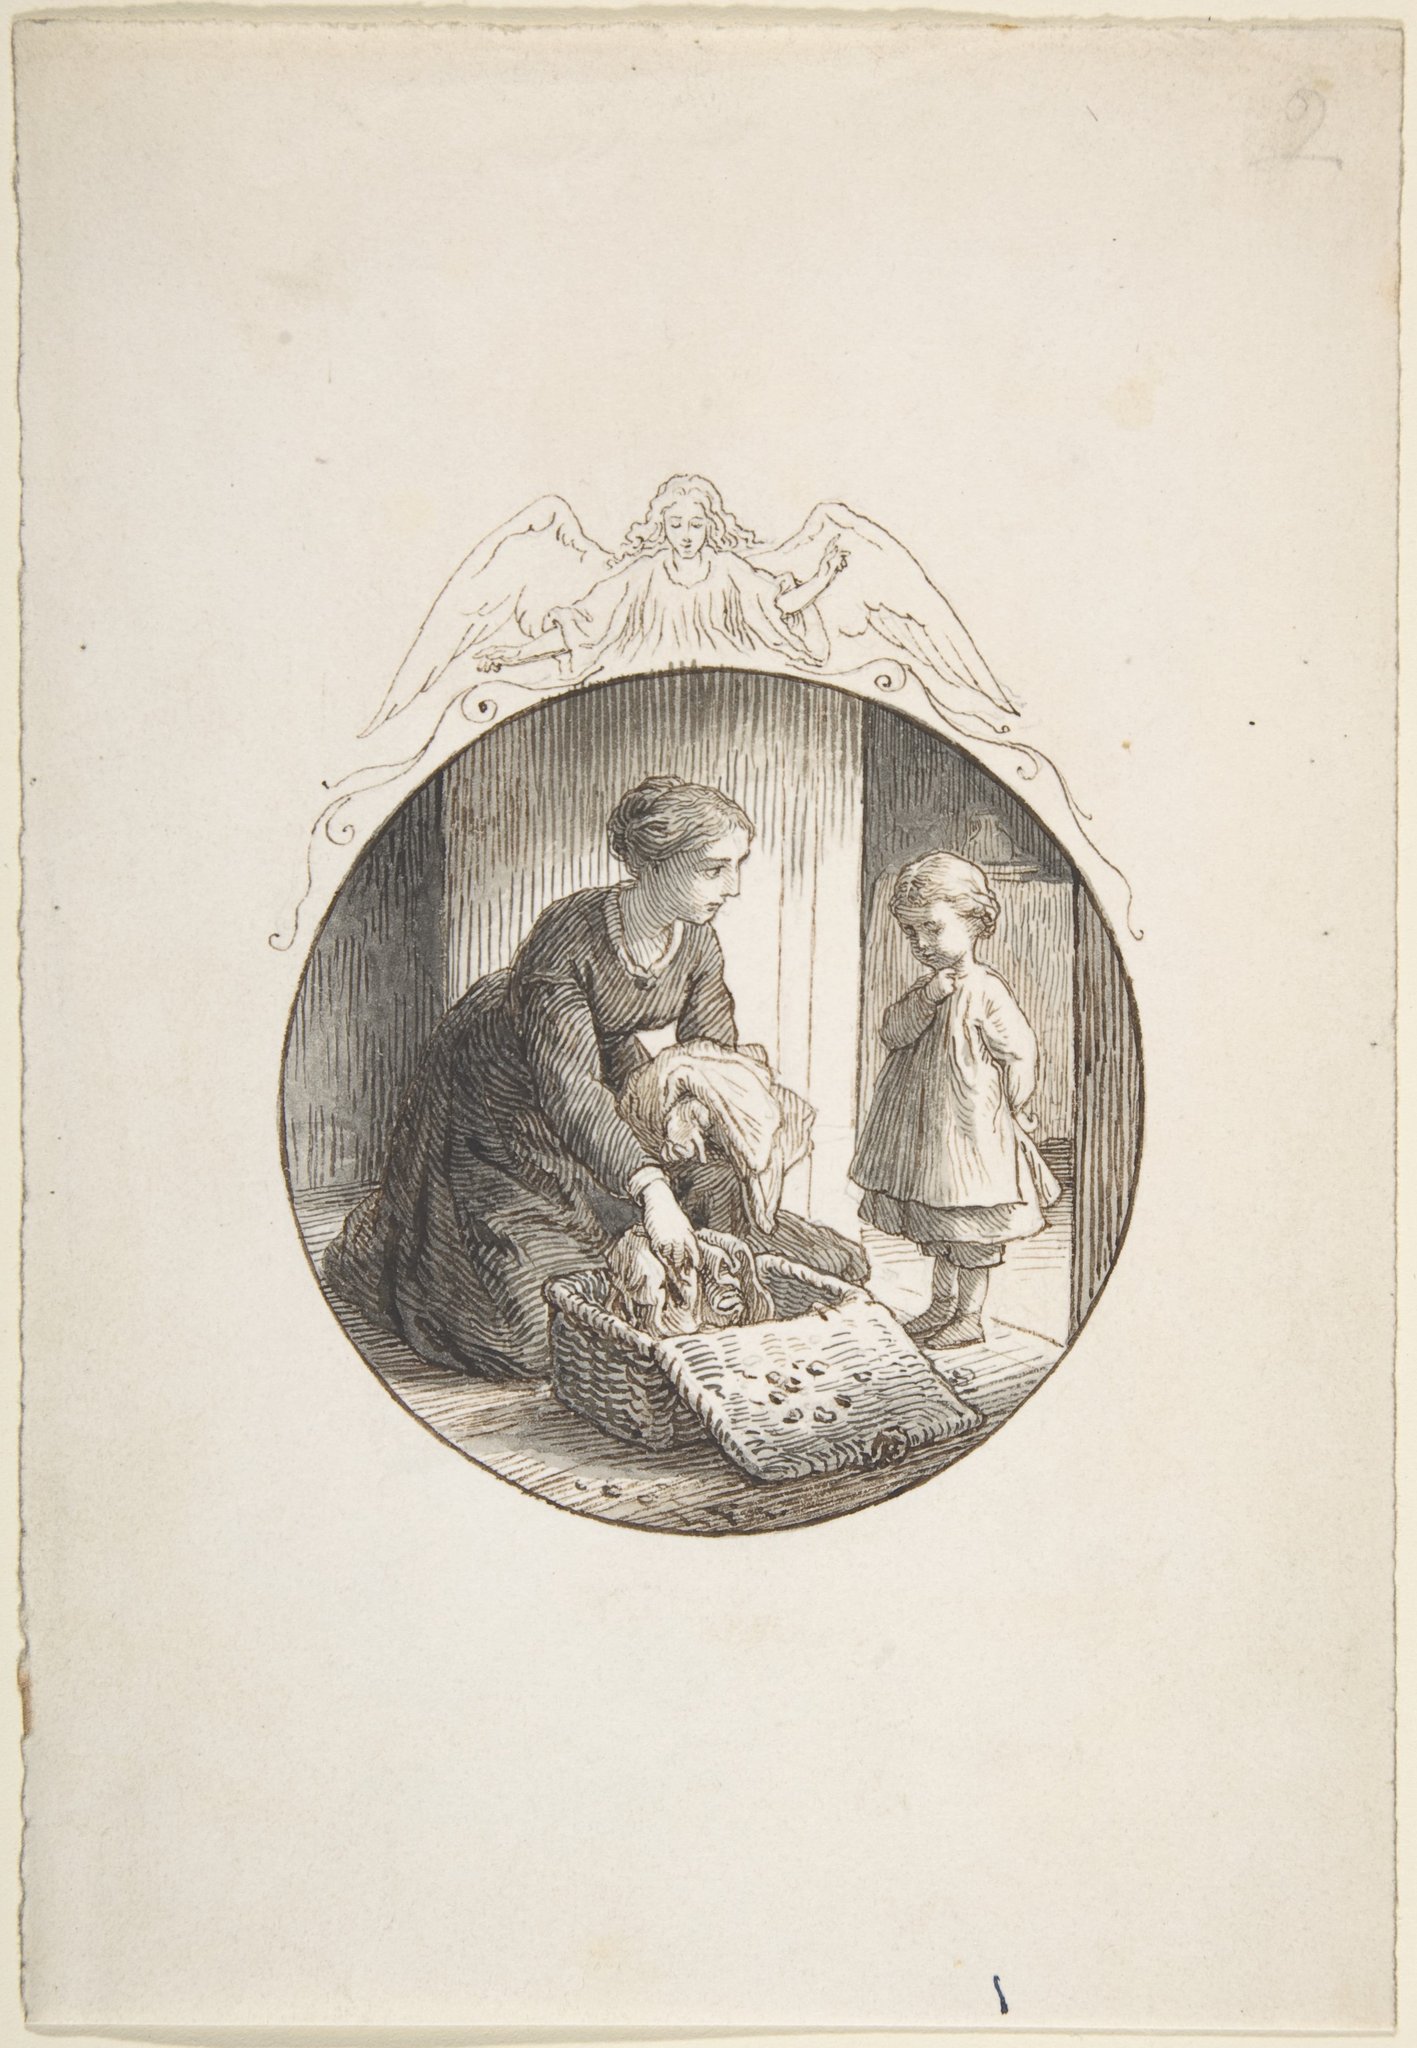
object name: drawing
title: Mother and Child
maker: lorenz frølich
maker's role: artist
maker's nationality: danish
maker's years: 1820-1908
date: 1835-1903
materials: graphite, ink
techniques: brush, pen, wash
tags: girls,mothers,fairies